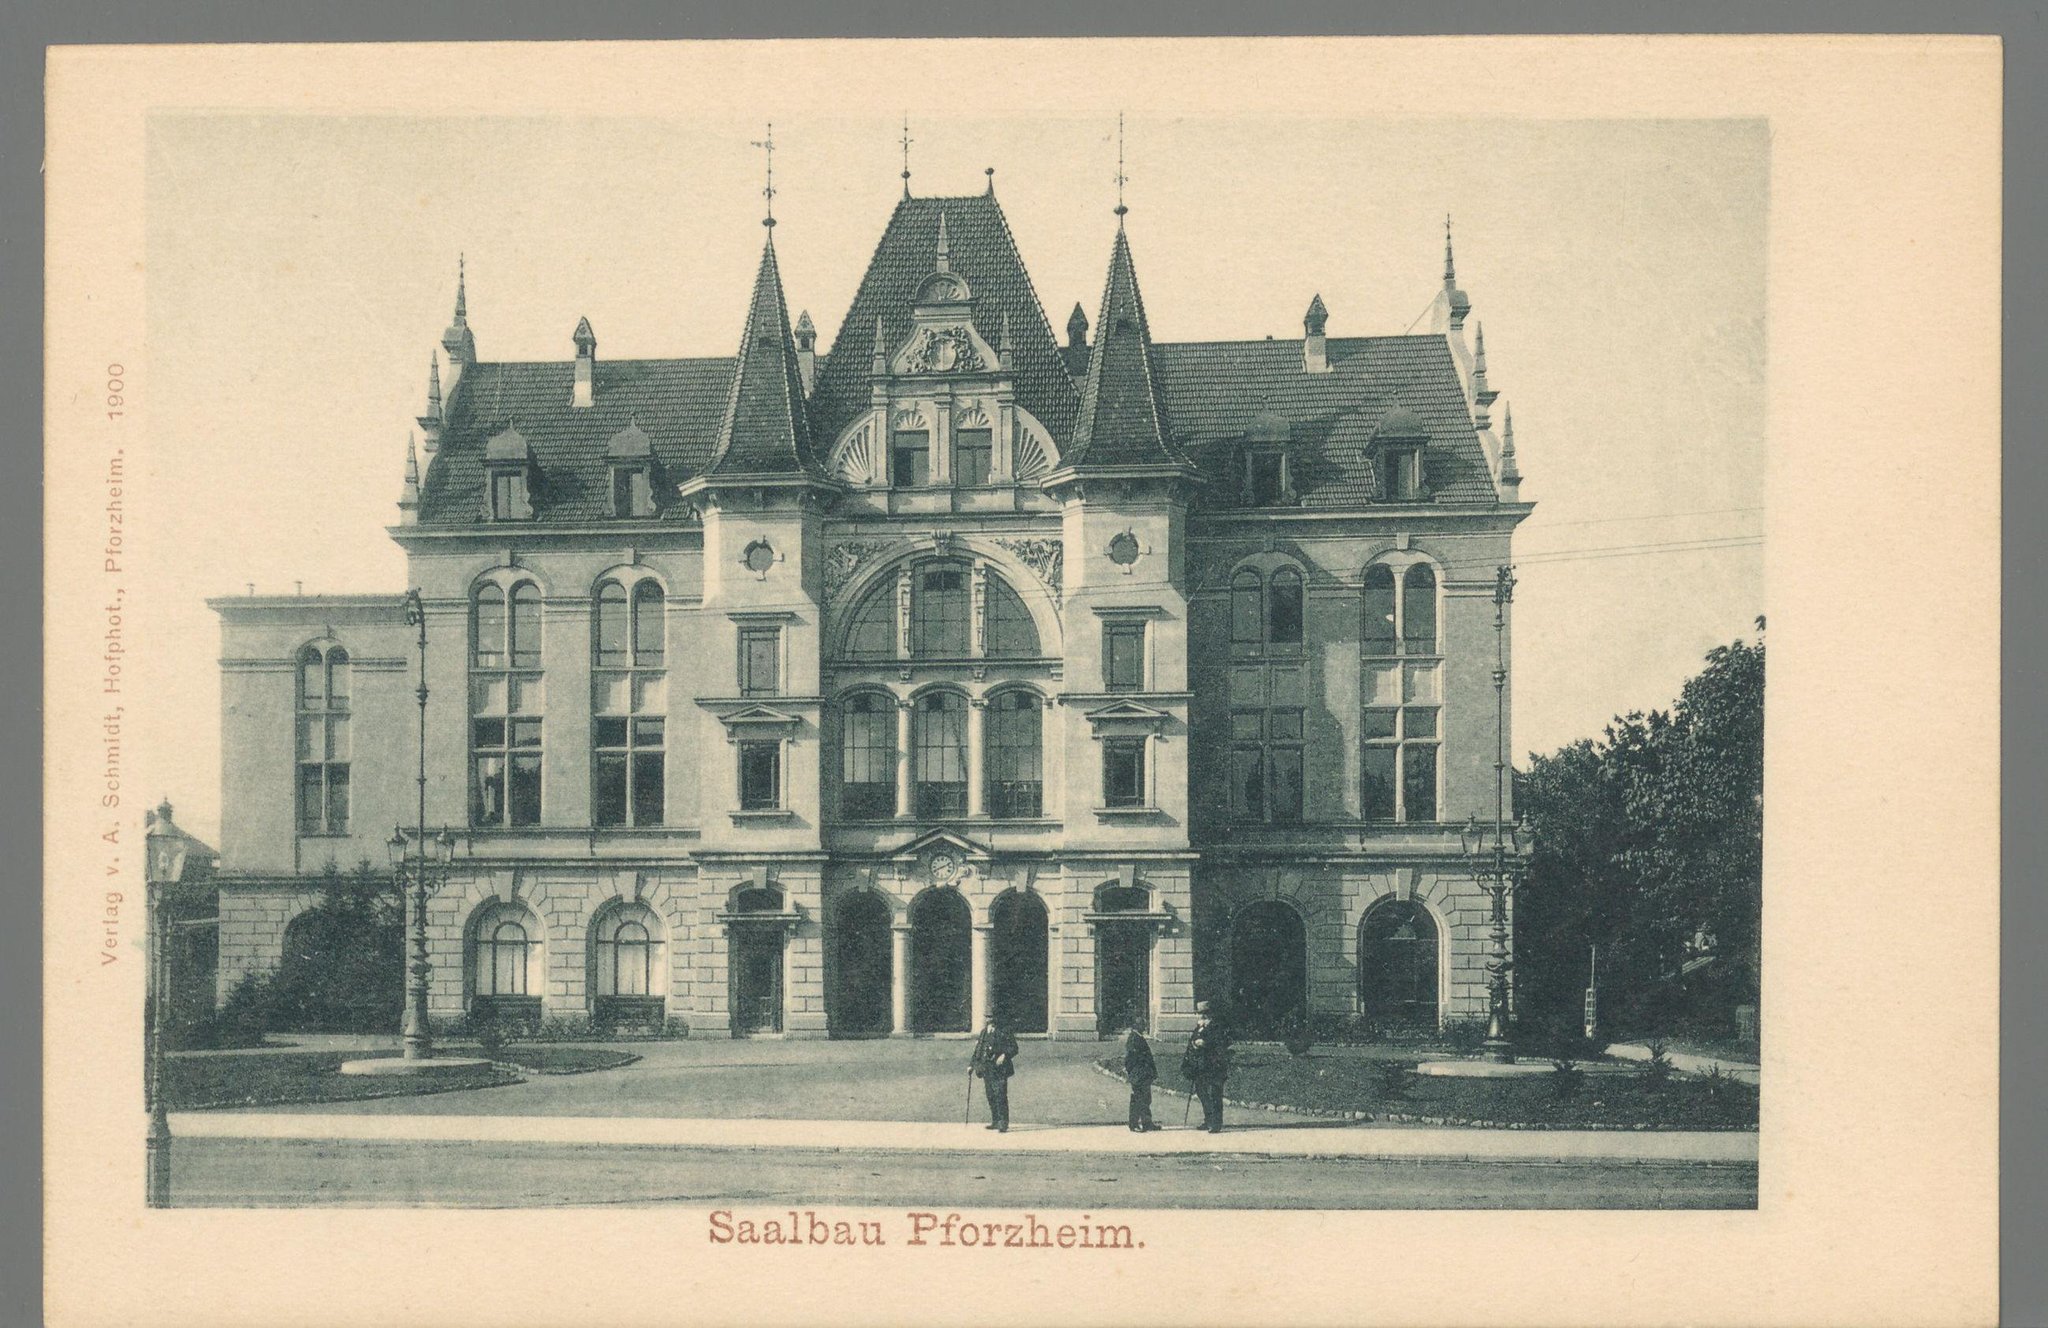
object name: photomechanical print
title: Saalbau Pforzheim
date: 1900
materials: cardboard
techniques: photograph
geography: pforzheim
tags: buildings for performances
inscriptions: date